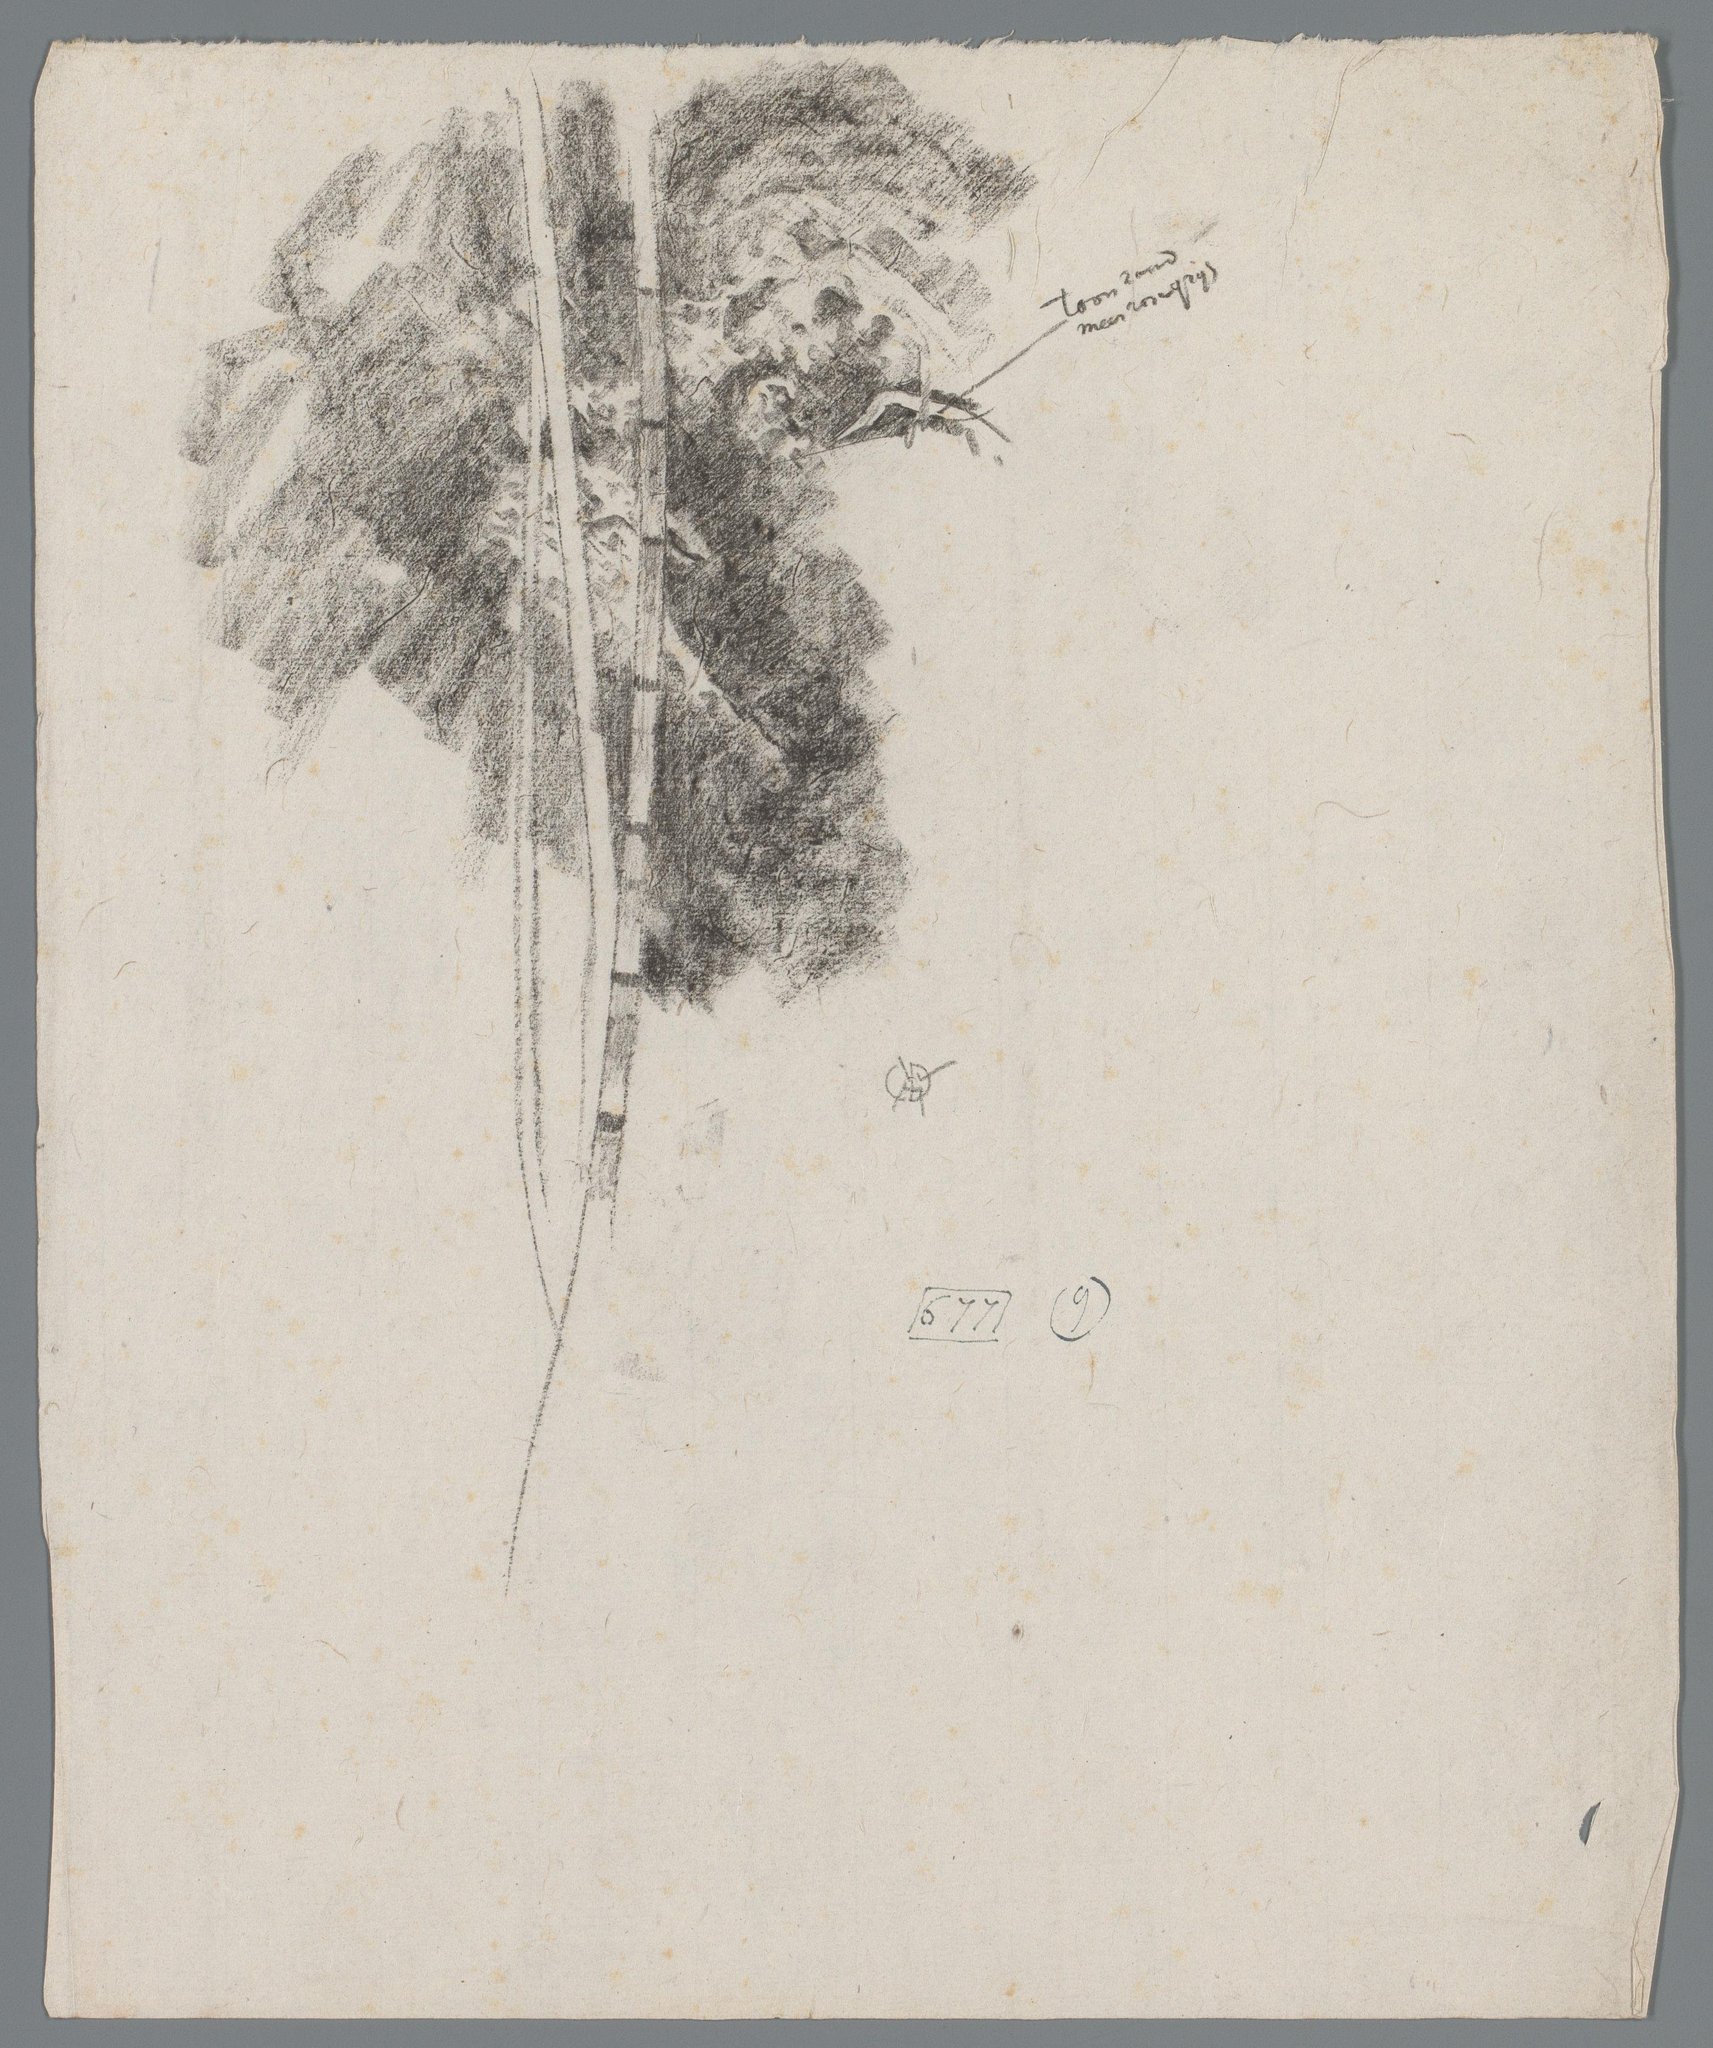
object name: drawing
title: Studie van een waterplant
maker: gerrit willem dijsselhof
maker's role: designer, draughtsman, print maker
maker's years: 1866-1924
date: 1876-1924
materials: chalk, paper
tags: plants (in general)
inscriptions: number: ‘9’, number: ‘676’